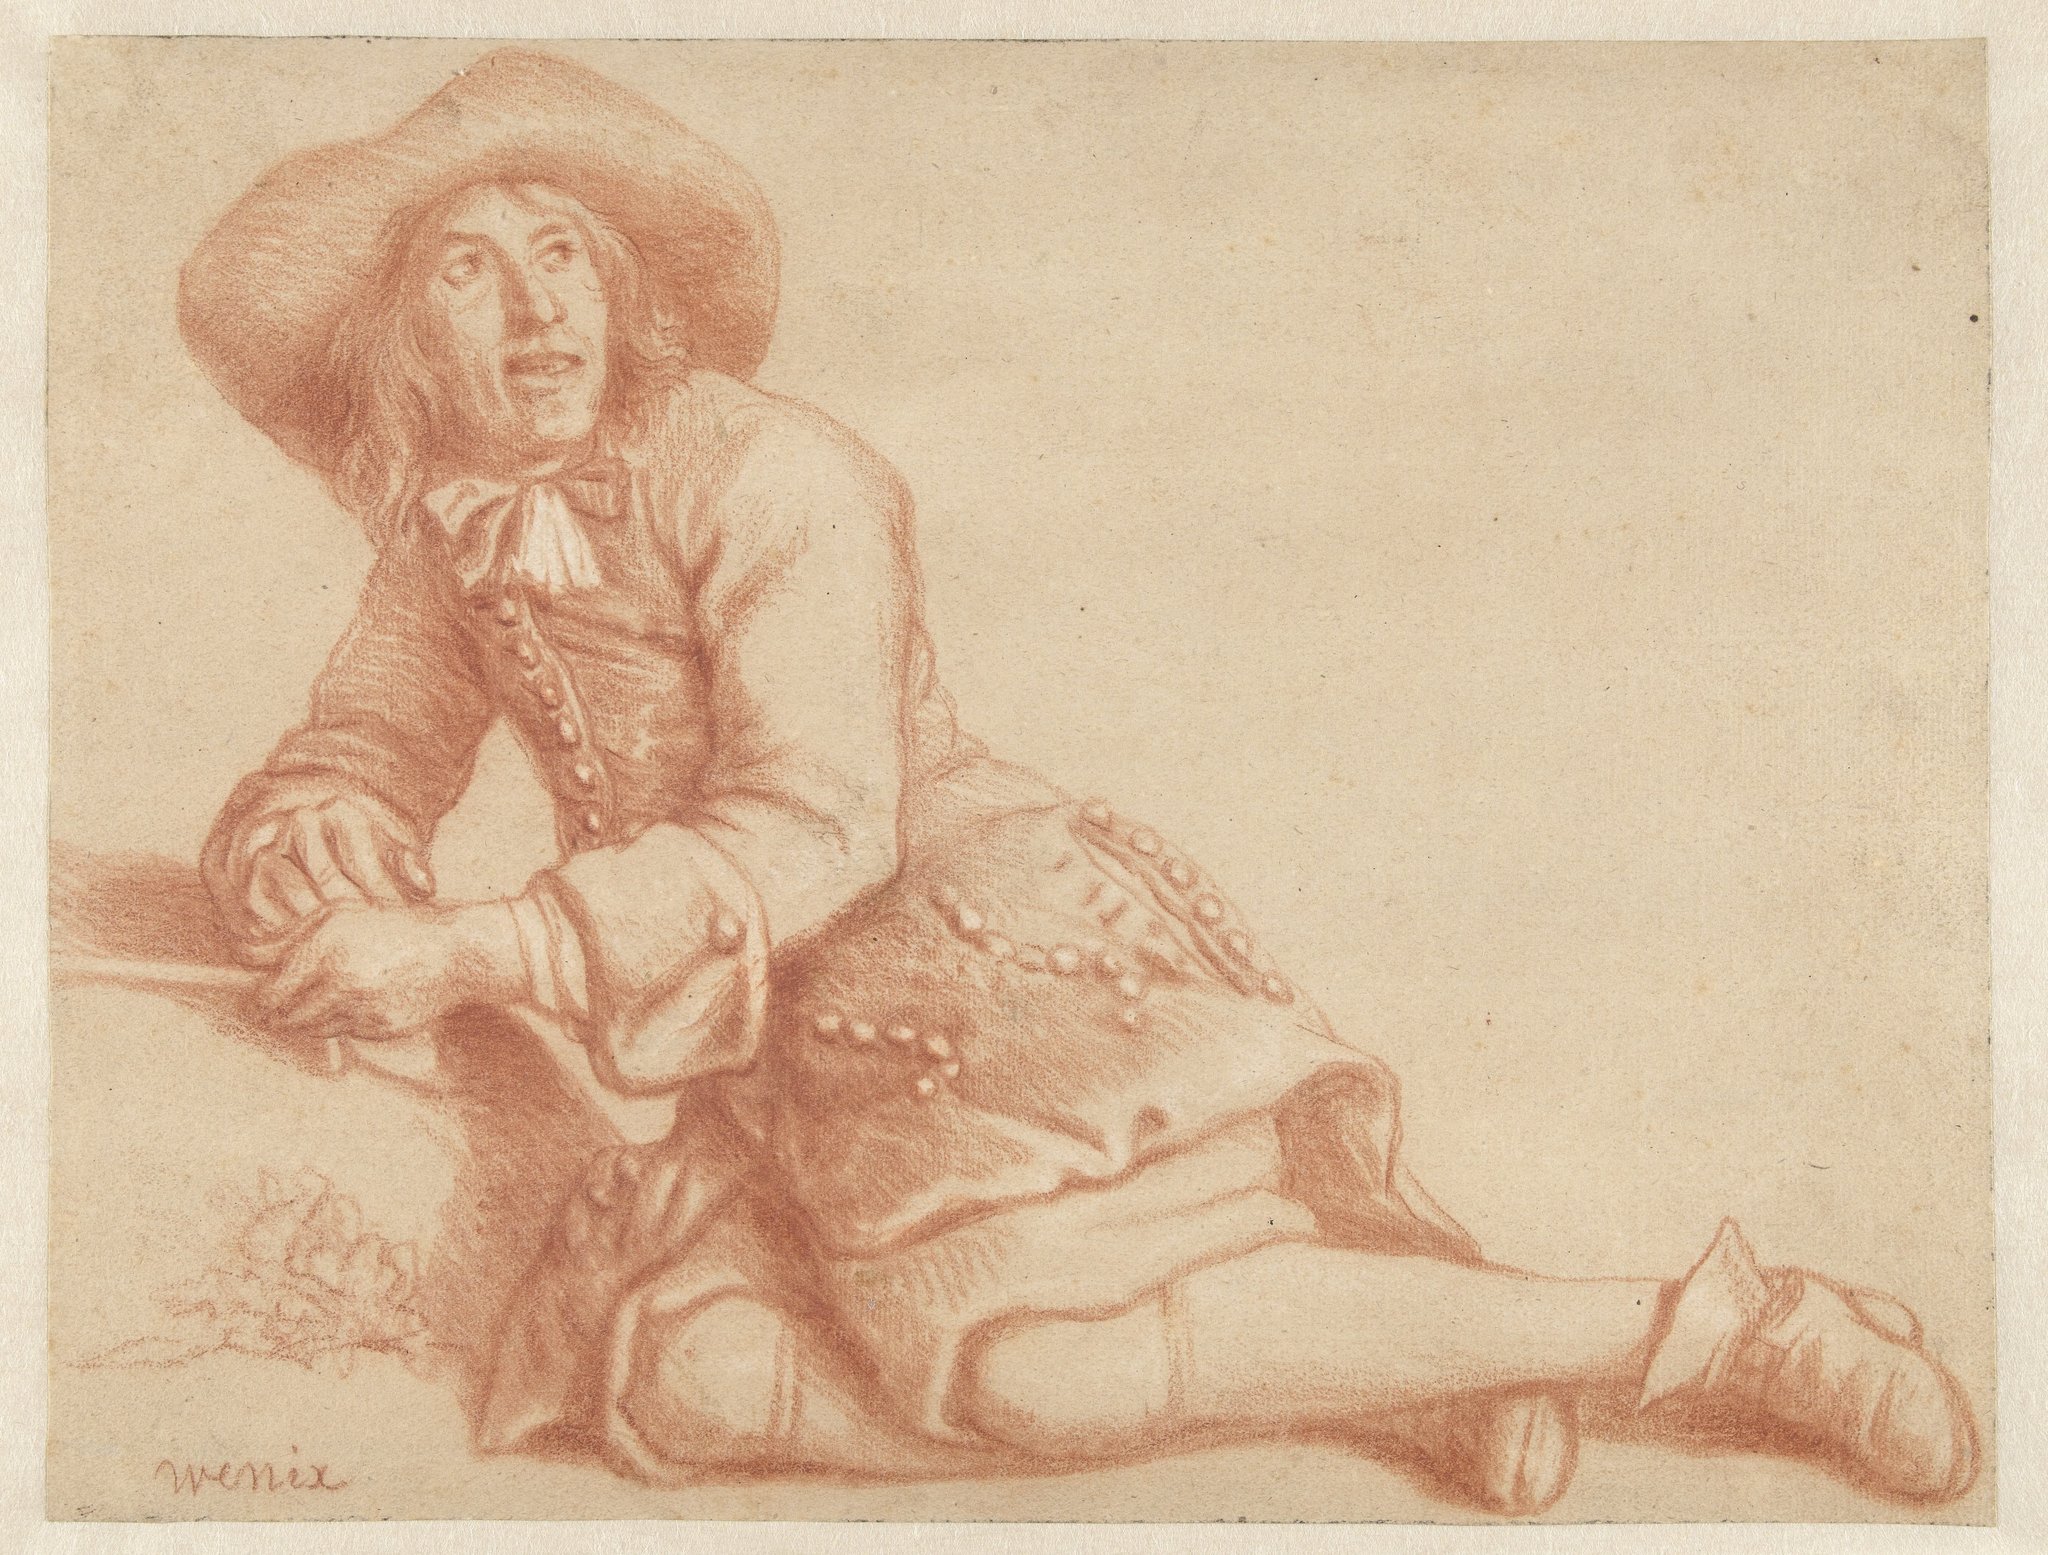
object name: drawing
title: Liggende man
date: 1631-1719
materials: chalk, paper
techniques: printmaking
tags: lying figure